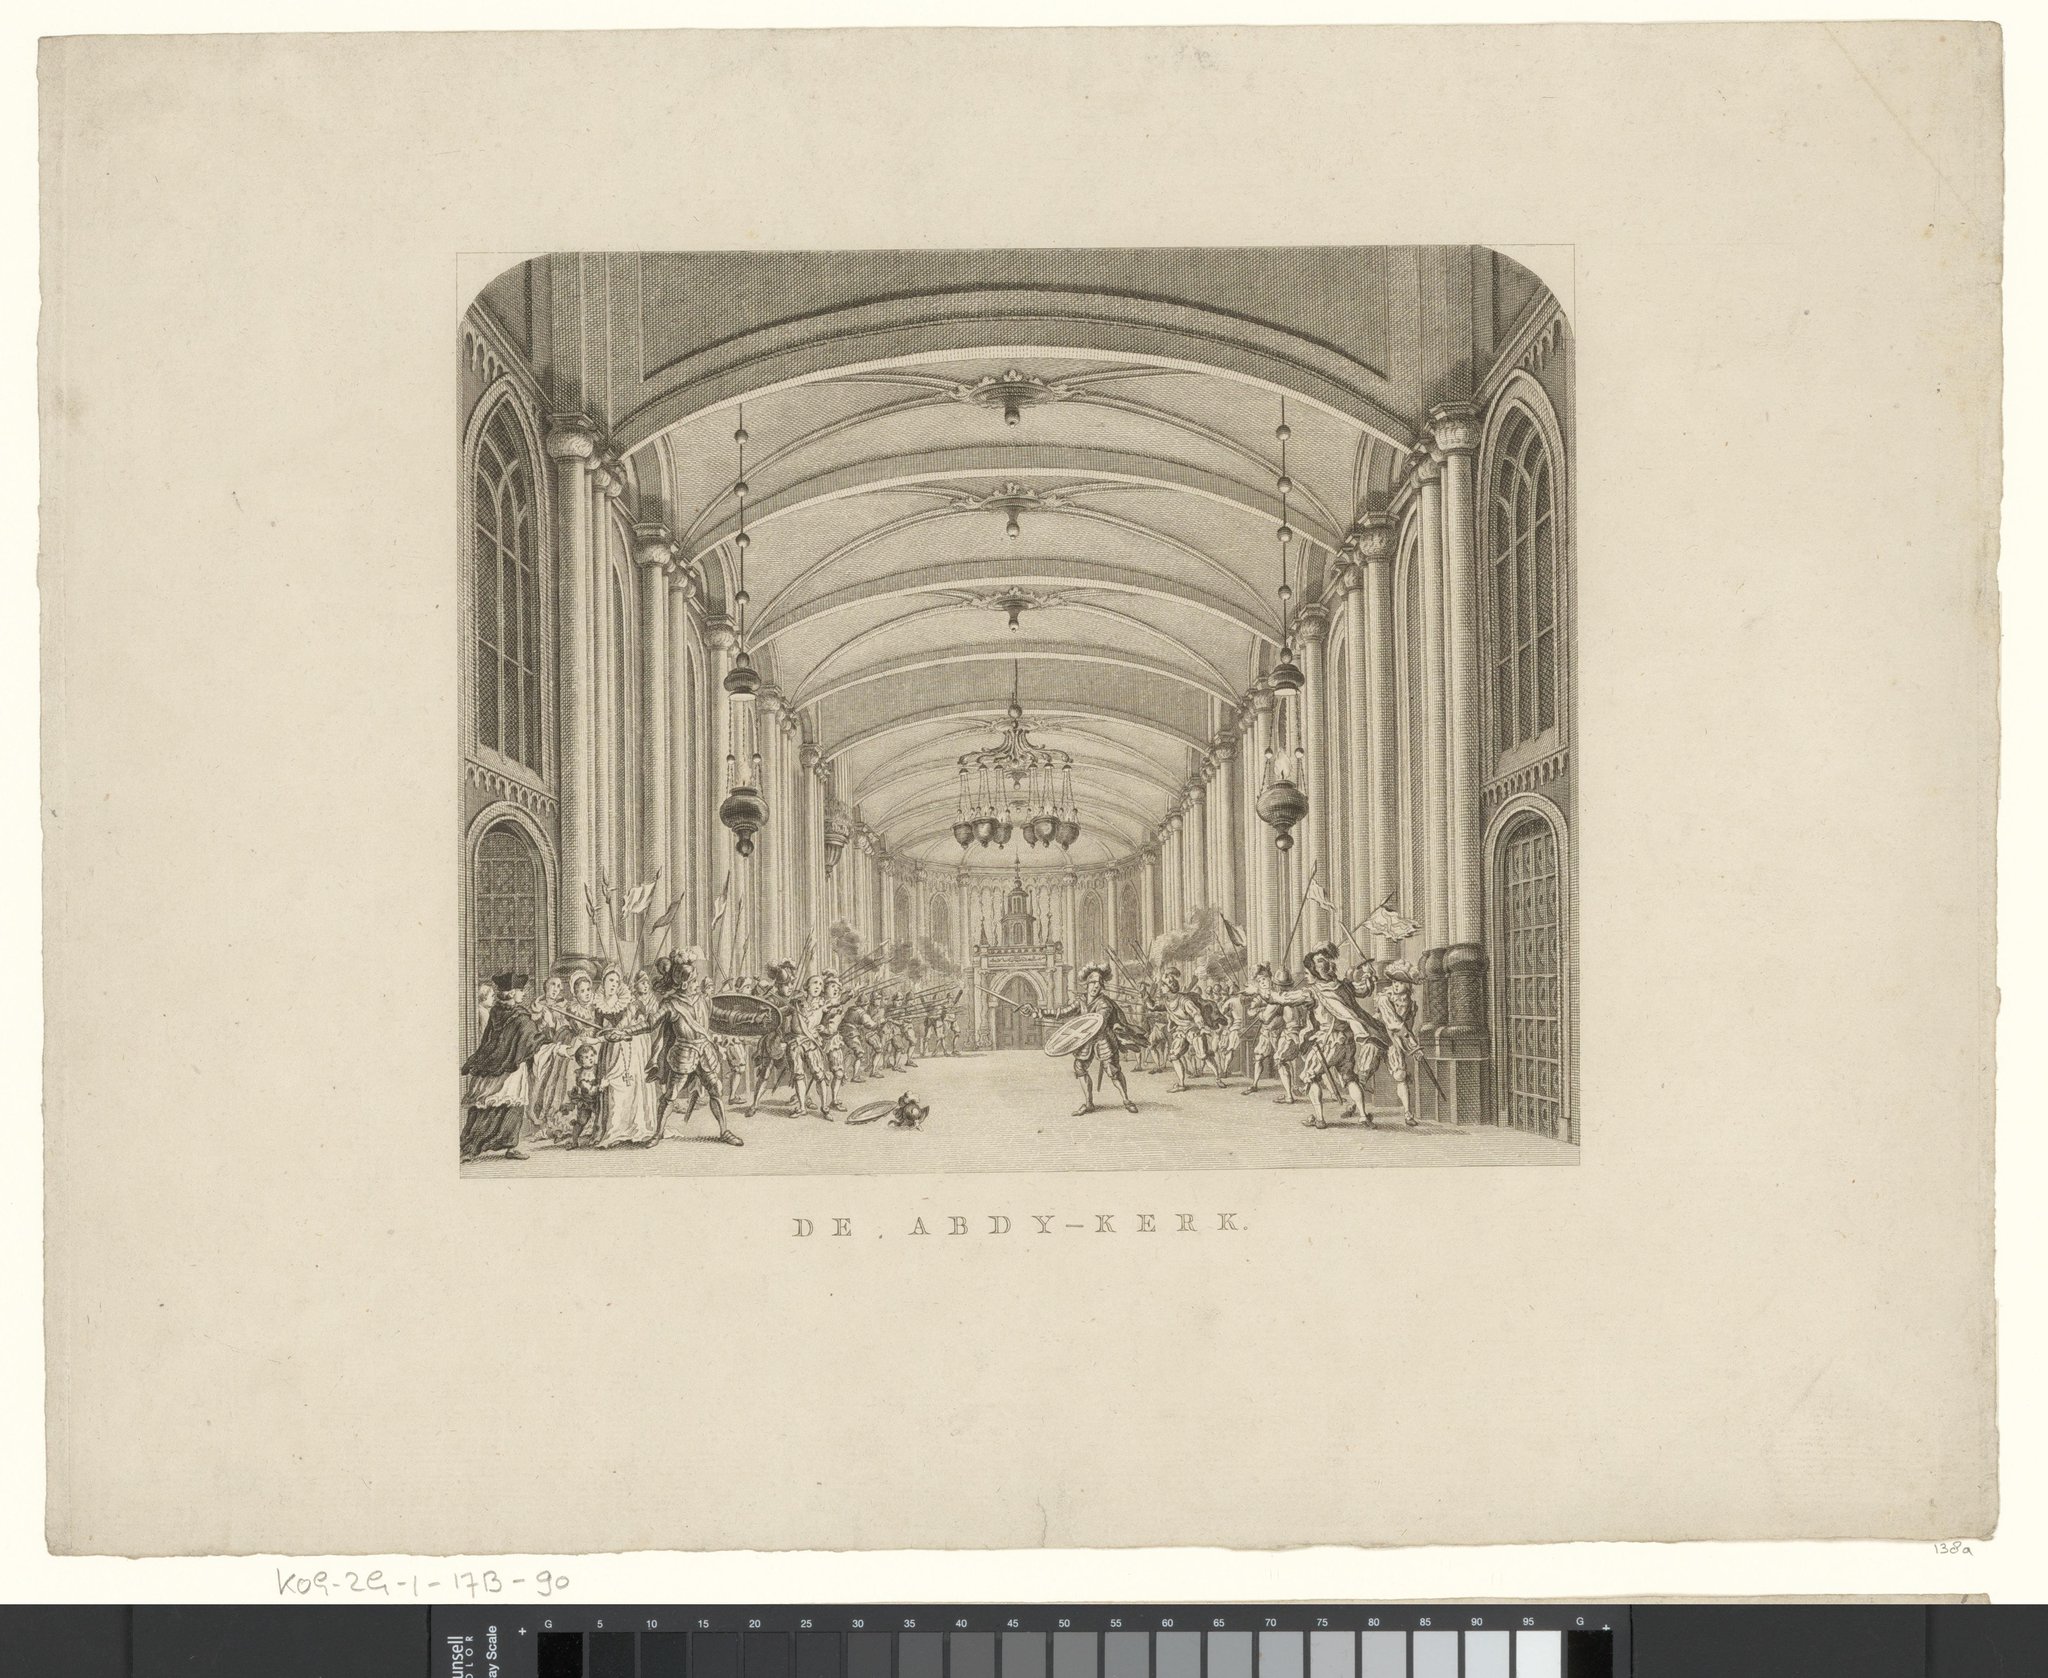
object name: print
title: De Abdy-Kerk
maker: cornelis brouwer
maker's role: print maker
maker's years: 1731-1803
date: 1791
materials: paper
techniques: etching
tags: theatre, theatrical performance, stage design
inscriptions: collector's mark: Lugt 1641, stamp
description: Toneelvoorstelling in de nieuwe Amsterdamse Schouwburg met het coulissendecor De Abdy-kerk met scène uit Robbert de Vries. Onderdeel van de serie van veertien toneeldecors van de nieuwe Amsterdamse Schouwburg, 1787-1794. Onderwerpsrubrieken binnen de Atlas Zeden en Gewoonten: Schoone kunsten, Tooneel, Decors voor de Schouwburg.